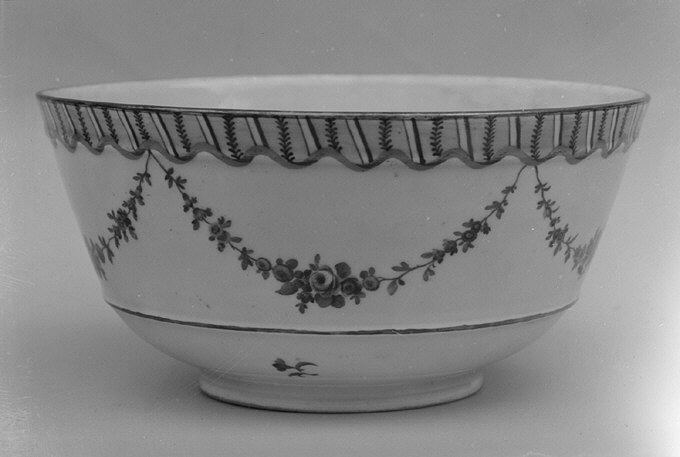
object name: bowl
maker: ludwigsburg porcelain manufactory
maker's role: manufactory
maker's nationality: german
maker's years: 1758-1824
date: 1770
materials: hard paste porcelain